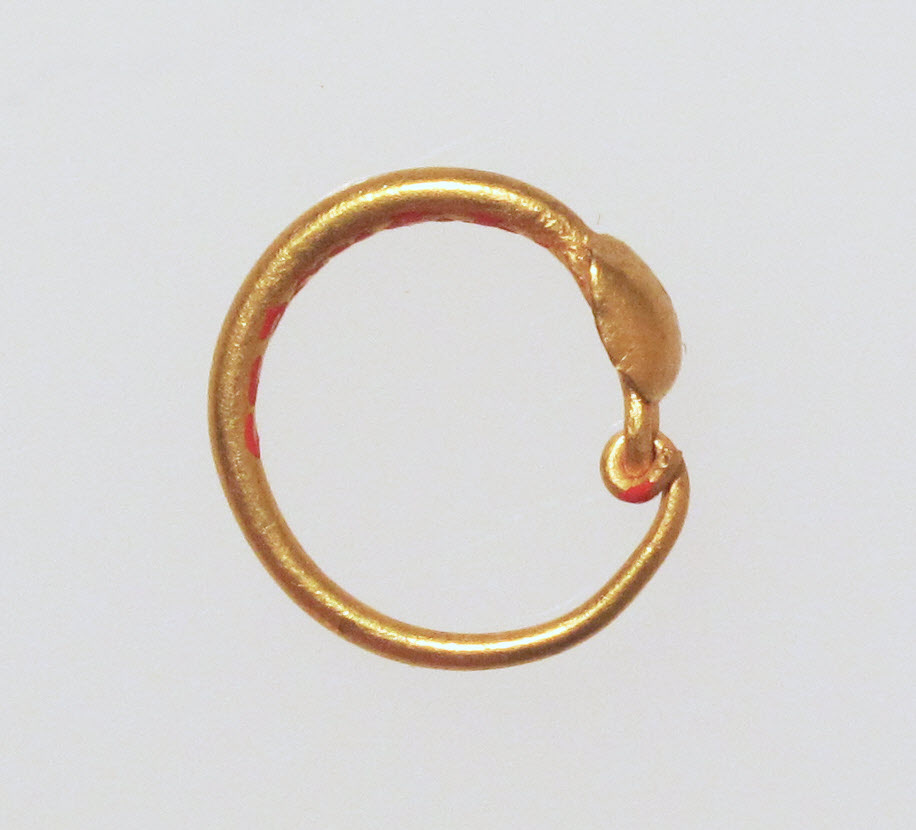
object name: earring with plain loop and disc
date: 7000 BCE-330 CE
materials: gold